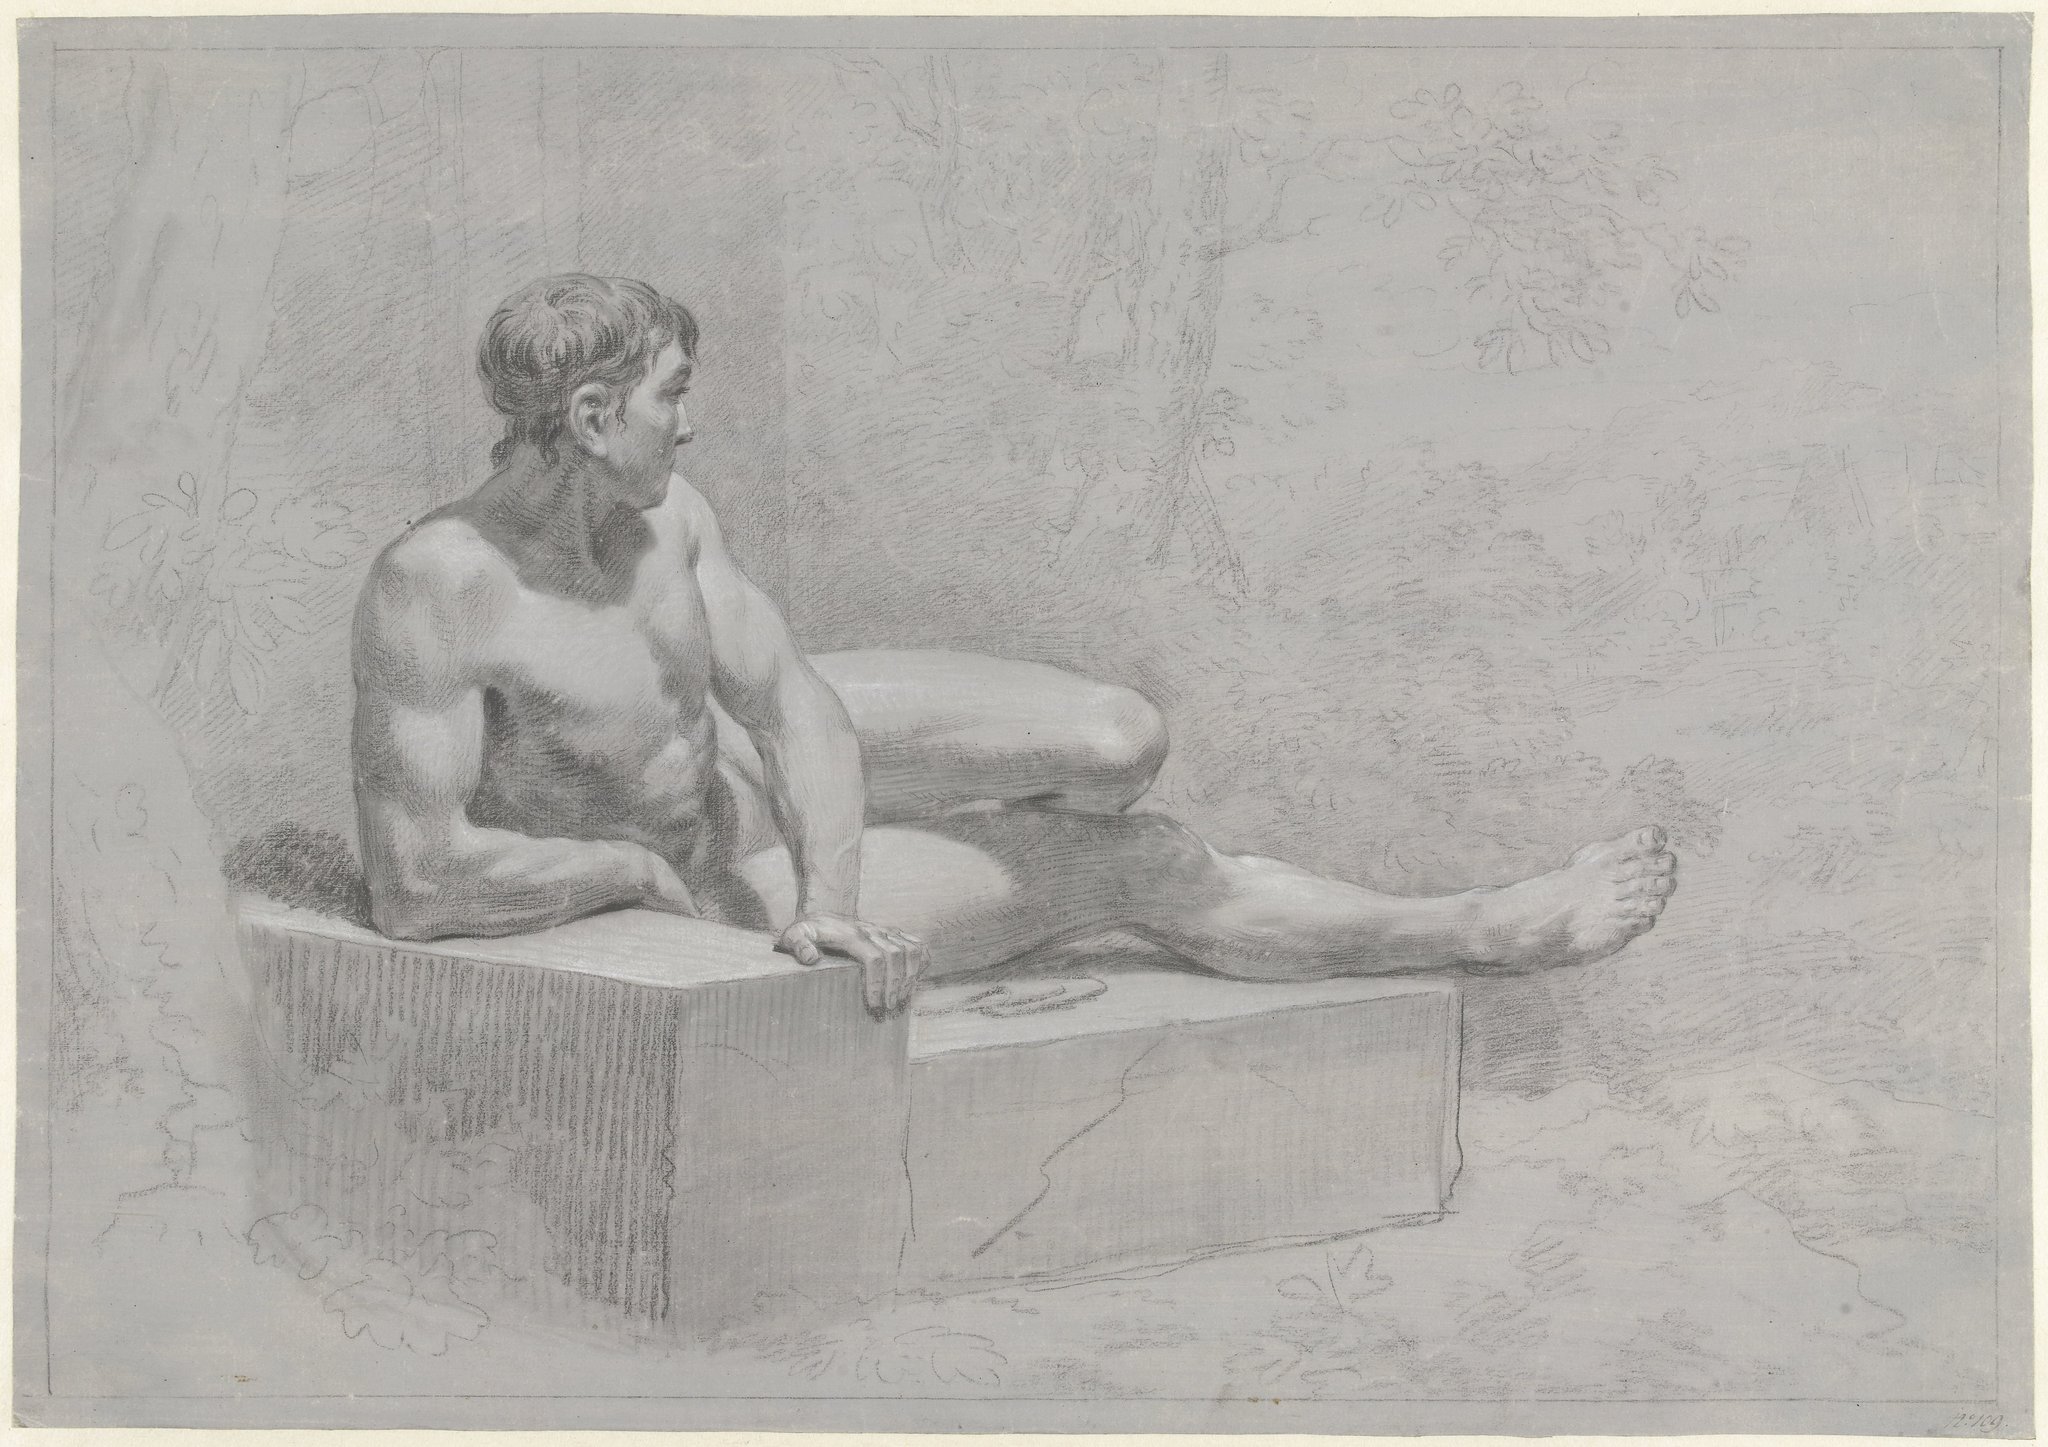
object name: drawing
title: Studie van een liggend mannelijk naakt, op een stenen bank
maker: egbert van drielst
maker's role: draughtsman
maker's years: 1745-1818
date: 1755-1818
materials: chalk, paper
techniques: brush